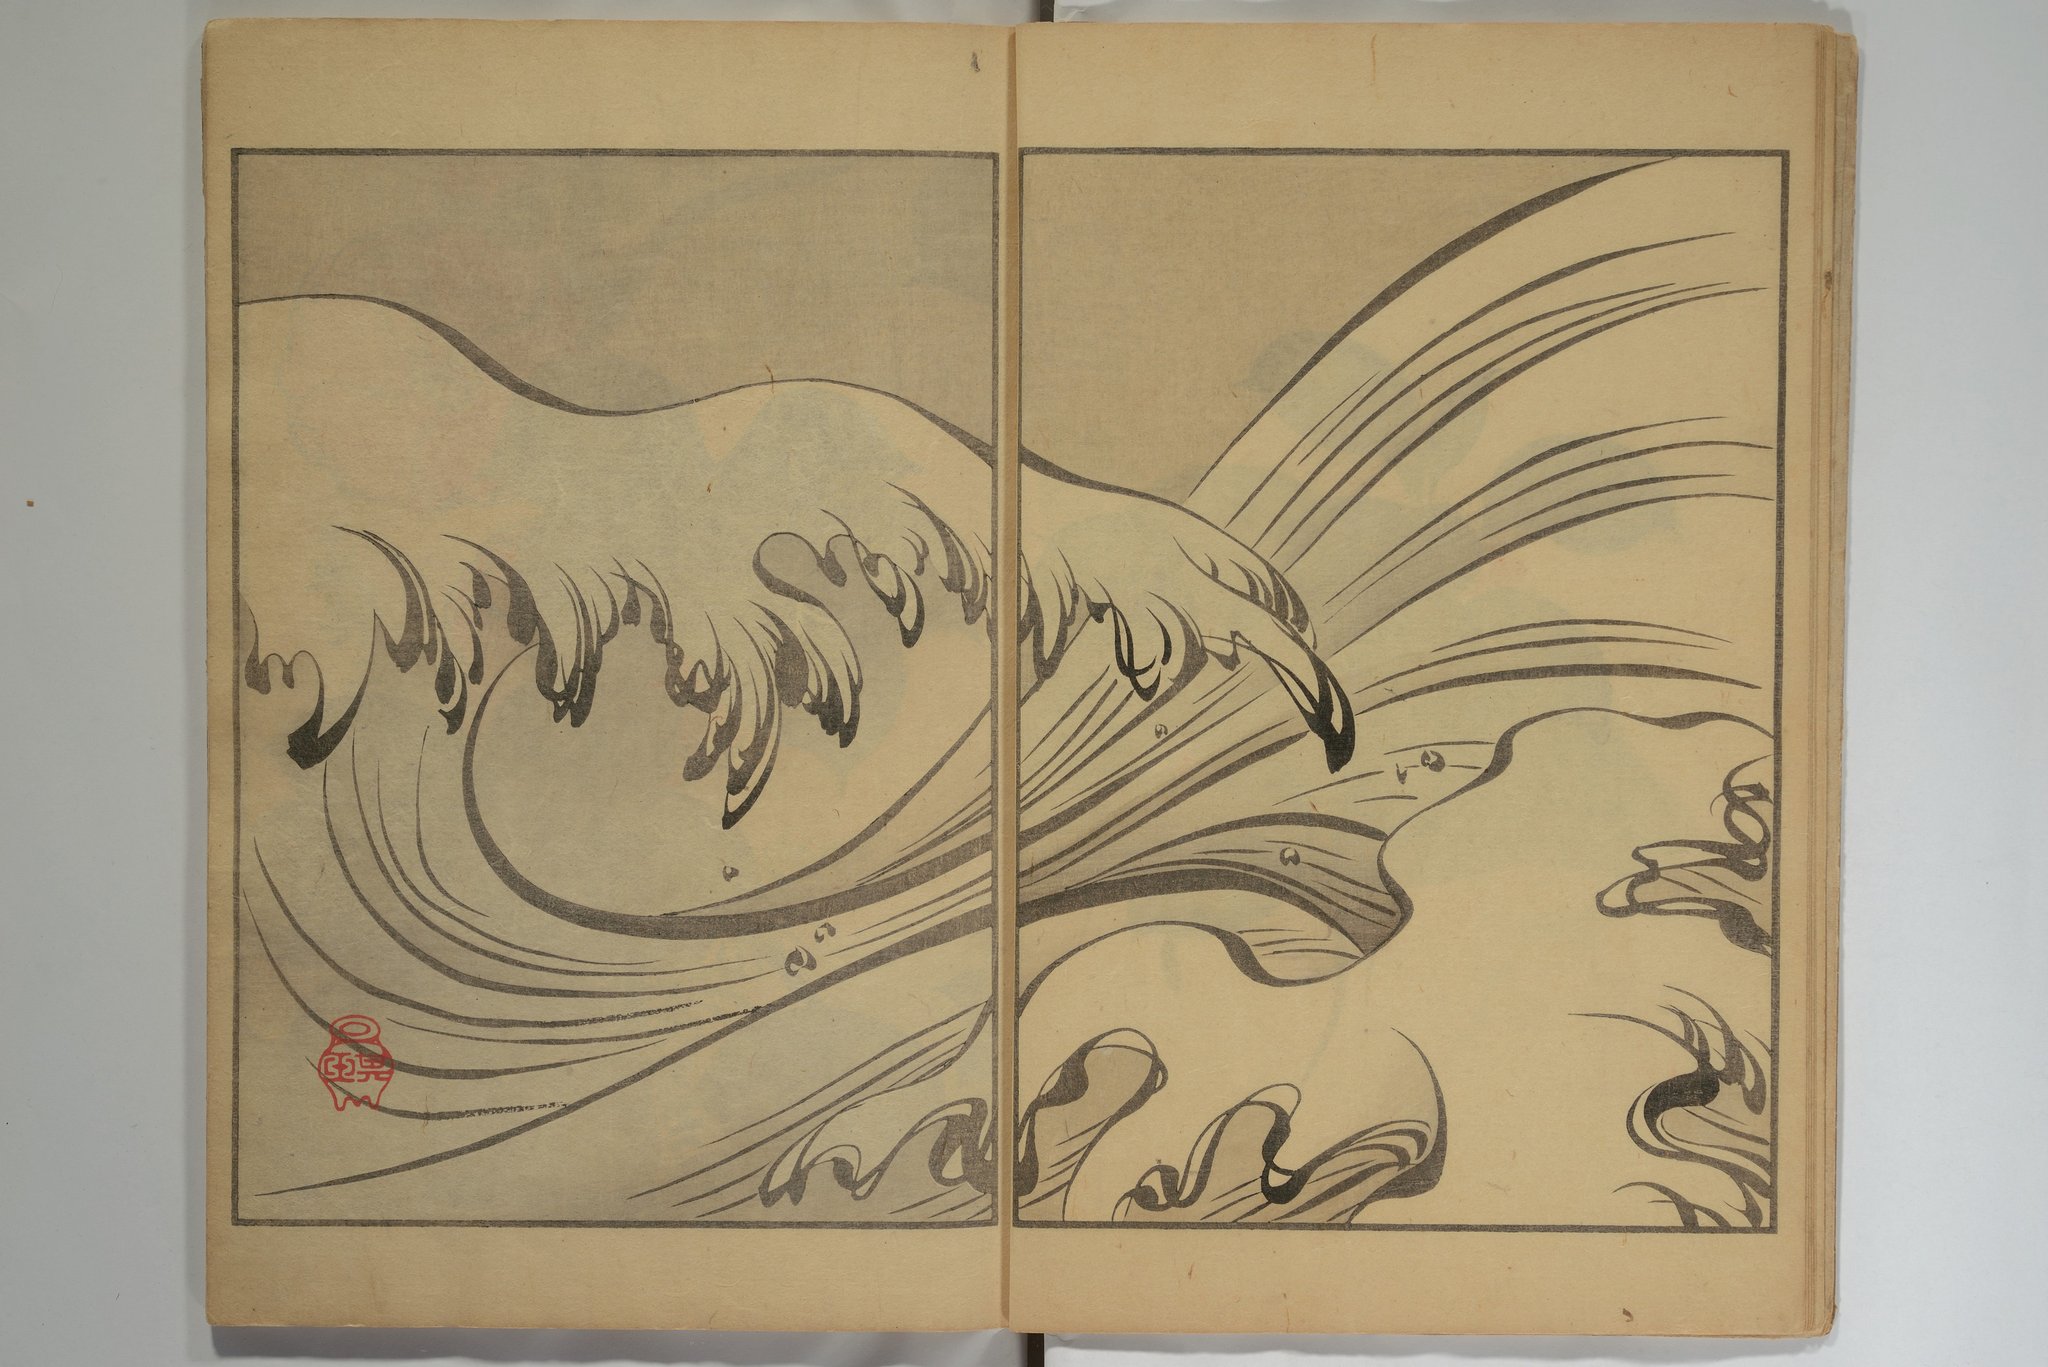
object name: illustrated book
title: Kigyoku Picture Album (Kigyoku gafu) 其玉画譜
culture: japanese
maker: seizei kigyoku 其玉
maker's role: artist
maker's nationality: japanese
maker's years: 1732-1756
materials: ink, paper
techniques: woodblock print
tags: waves